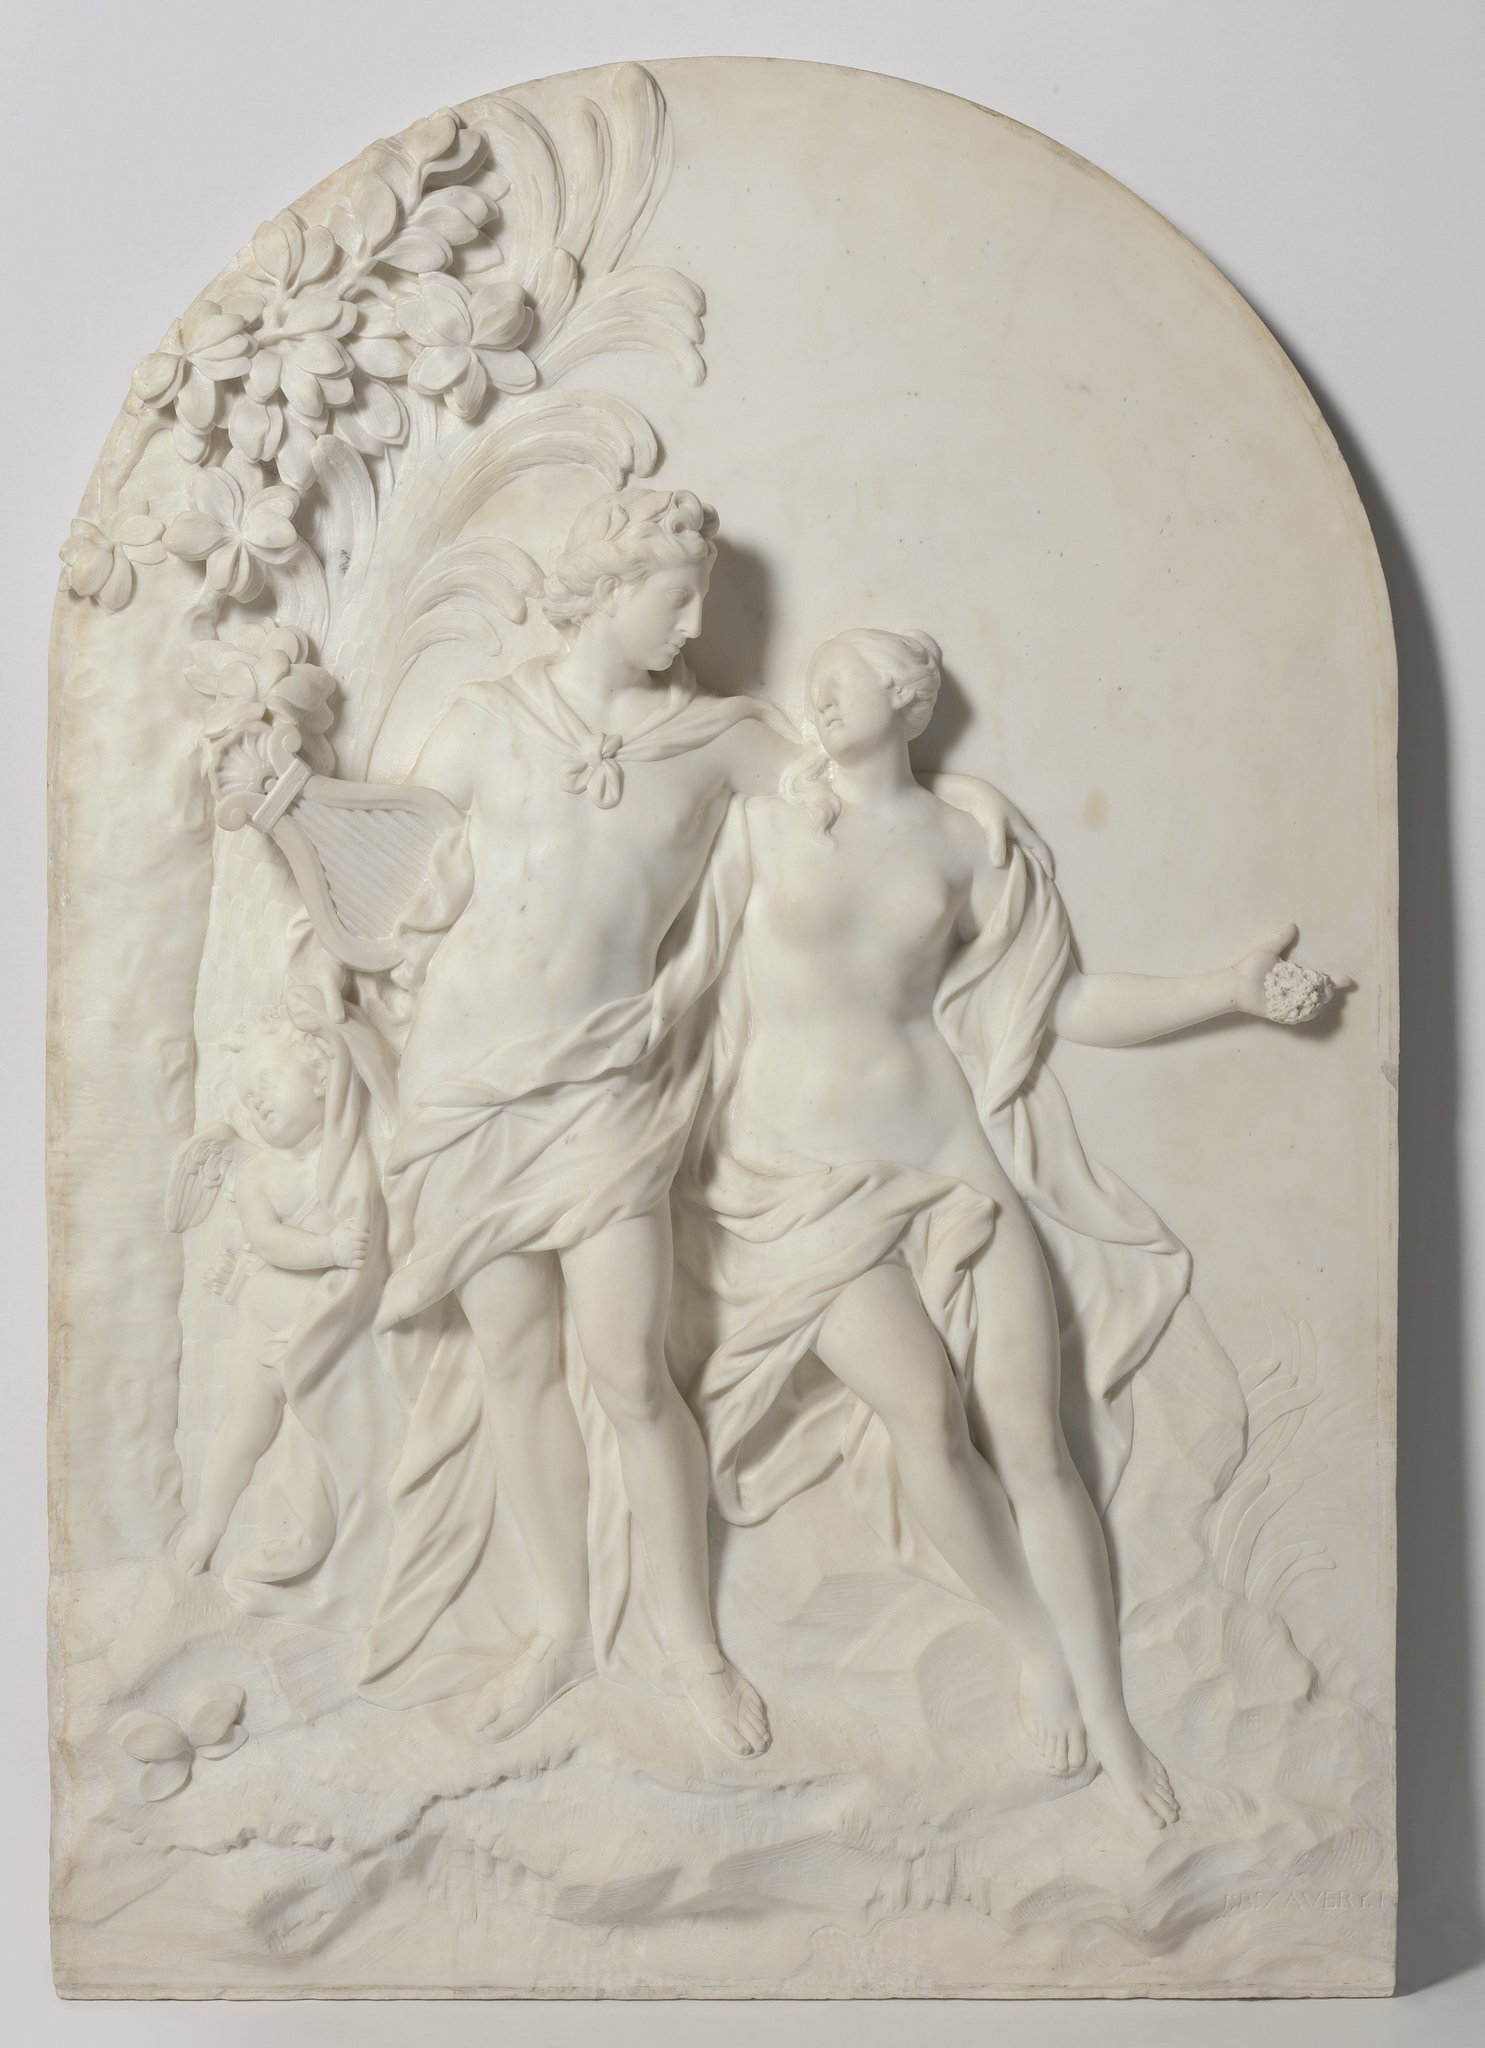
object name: schoorsteenfries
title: Schoorsteenstuk met Apollo en de Cumeïsche sibylle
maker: jan baptist xavery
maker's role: sculptor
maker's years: 1697-1742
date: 1742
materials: marble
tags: (story of) apollo (phoebus)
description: Jan Baptist Xavery (1697 - 1742). Chimney-piece: Apollo and the Cumaean sybilla. Marble. The Hague, 1742. Made for Stadholder Willem IV of Orange for his palace Huis Ten Bosch in The Hague.